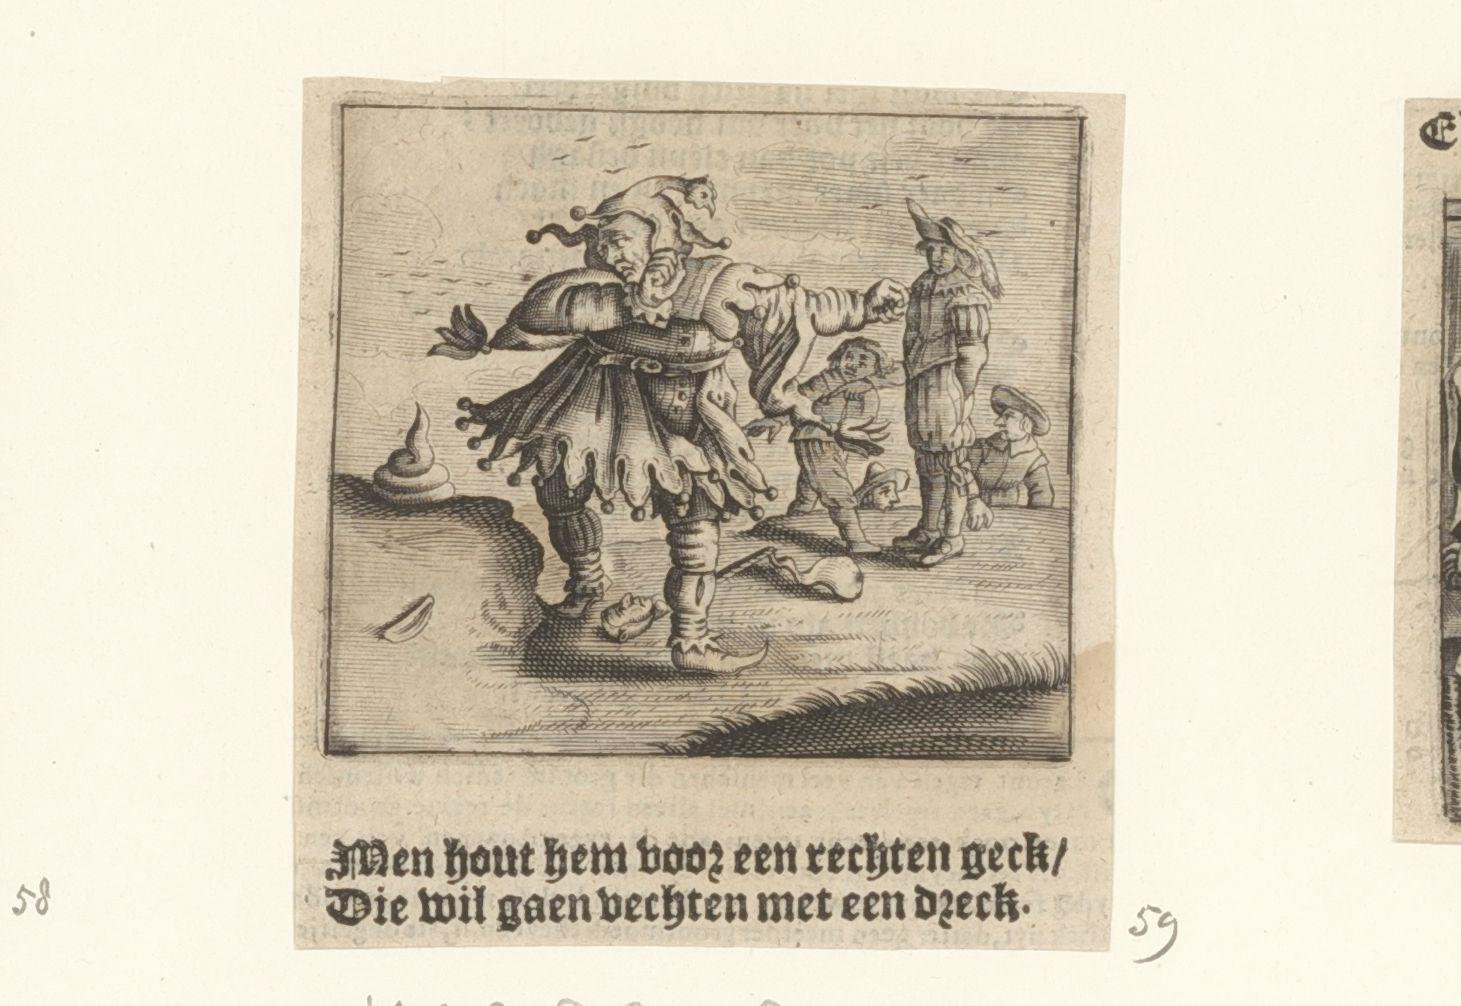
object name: print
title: Nar kijkt naar een drol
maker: Anonymous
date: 1635-1715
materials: paper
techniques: engraving, letterpress printing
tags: court jester, court fool, proverbs, sayings, etc.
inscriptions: stamp, collector's mark: Lugt 1641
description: Veel versies van dit embleem verschenen in verschillende uitgave van Spiegel van den Ouden ende Nieuwen Tydt. Zoals: Cats, Jacob. Spiegel van den Ouden ende Nieuwen-tijt, Bestaende uyt Spreeck-woorden (...). Dordrecht: Jacob Braat, 1647. Maar ook in andere publicaties (1665, 1671, 1715, 1722).